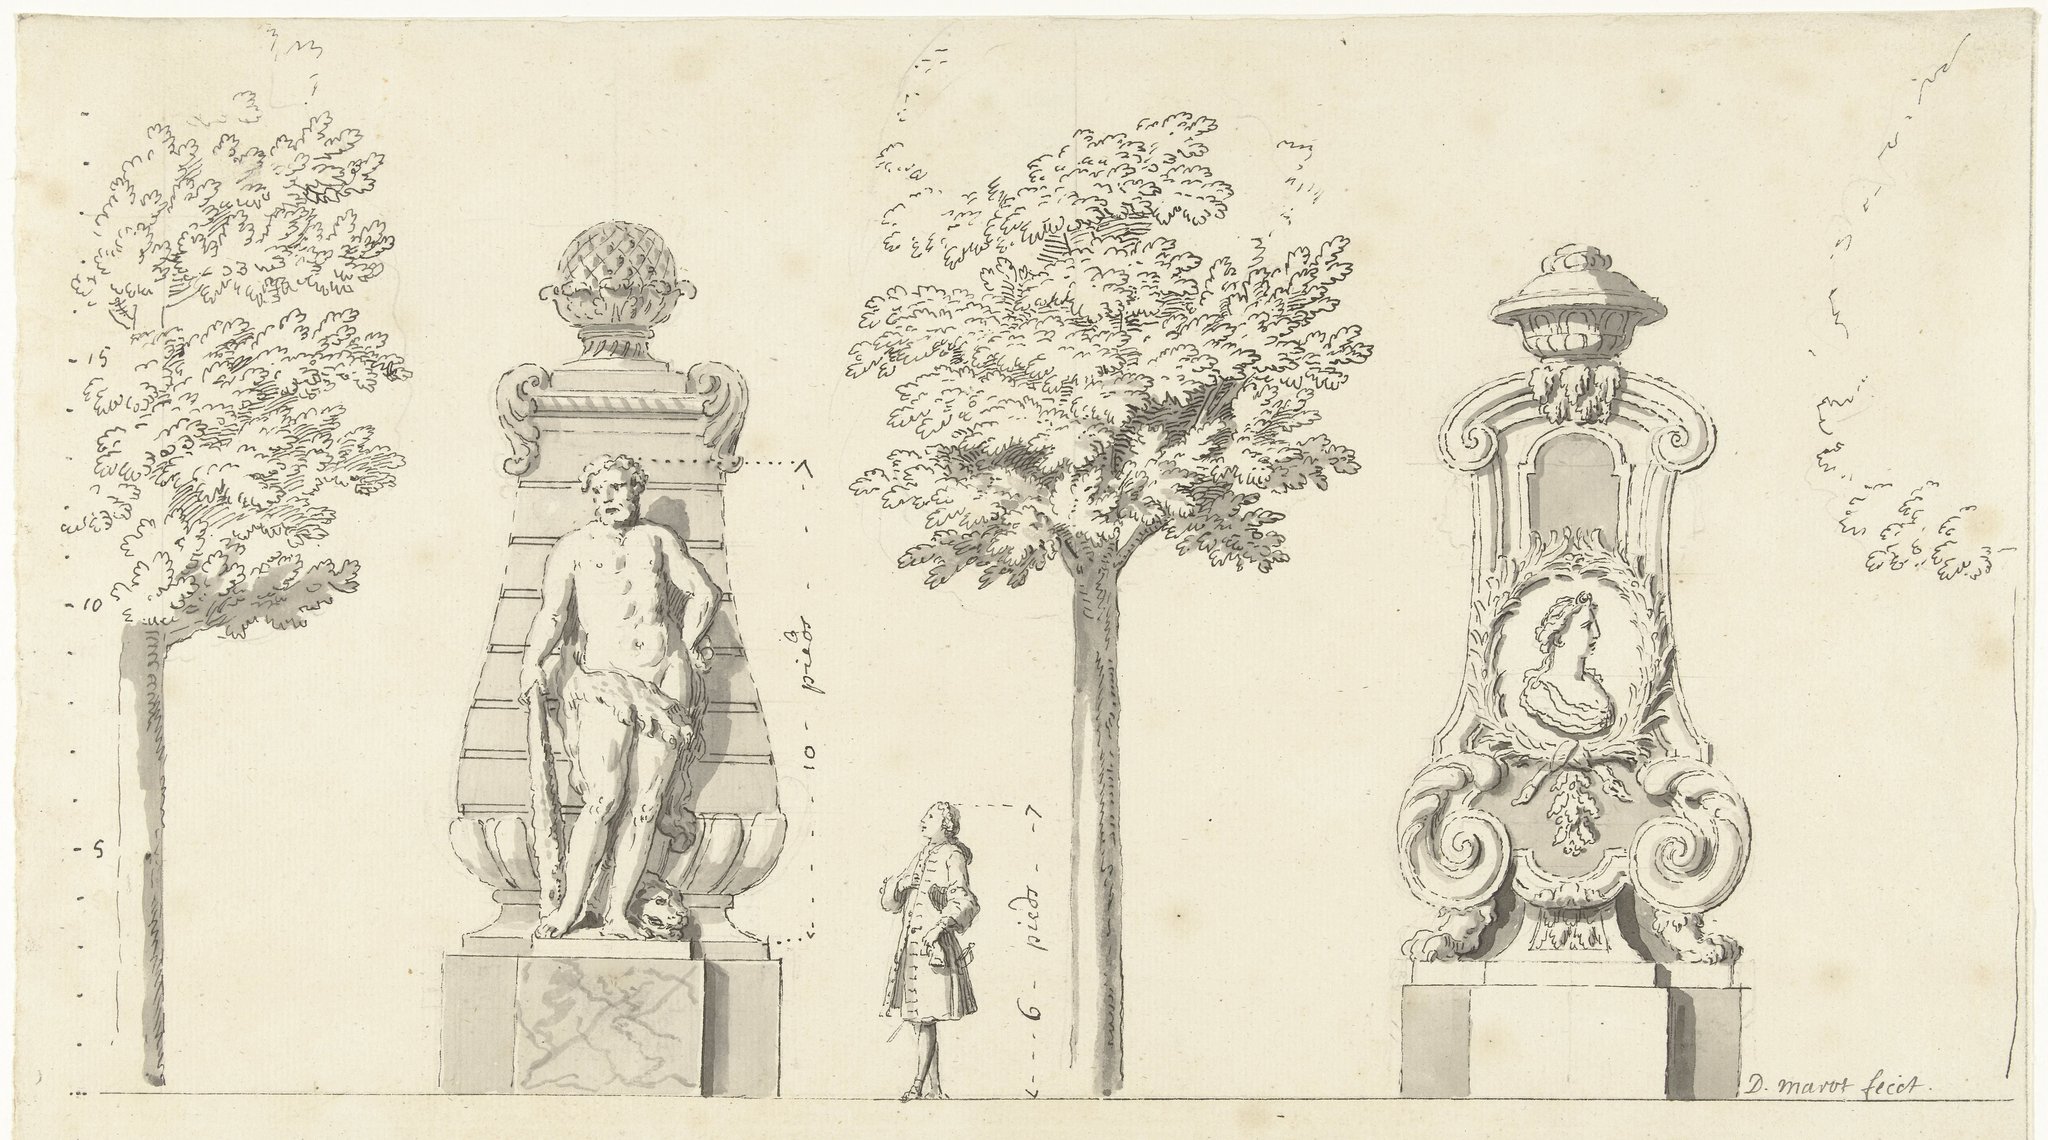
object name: design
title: Ontwerpen voor twee tuinornamenten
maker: daniël marot (ii)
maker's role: draughtsman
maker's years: 1695-1769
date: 1705-1769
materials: ink, paper, pencil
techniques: brush, pen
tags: statues, sculptures in garden